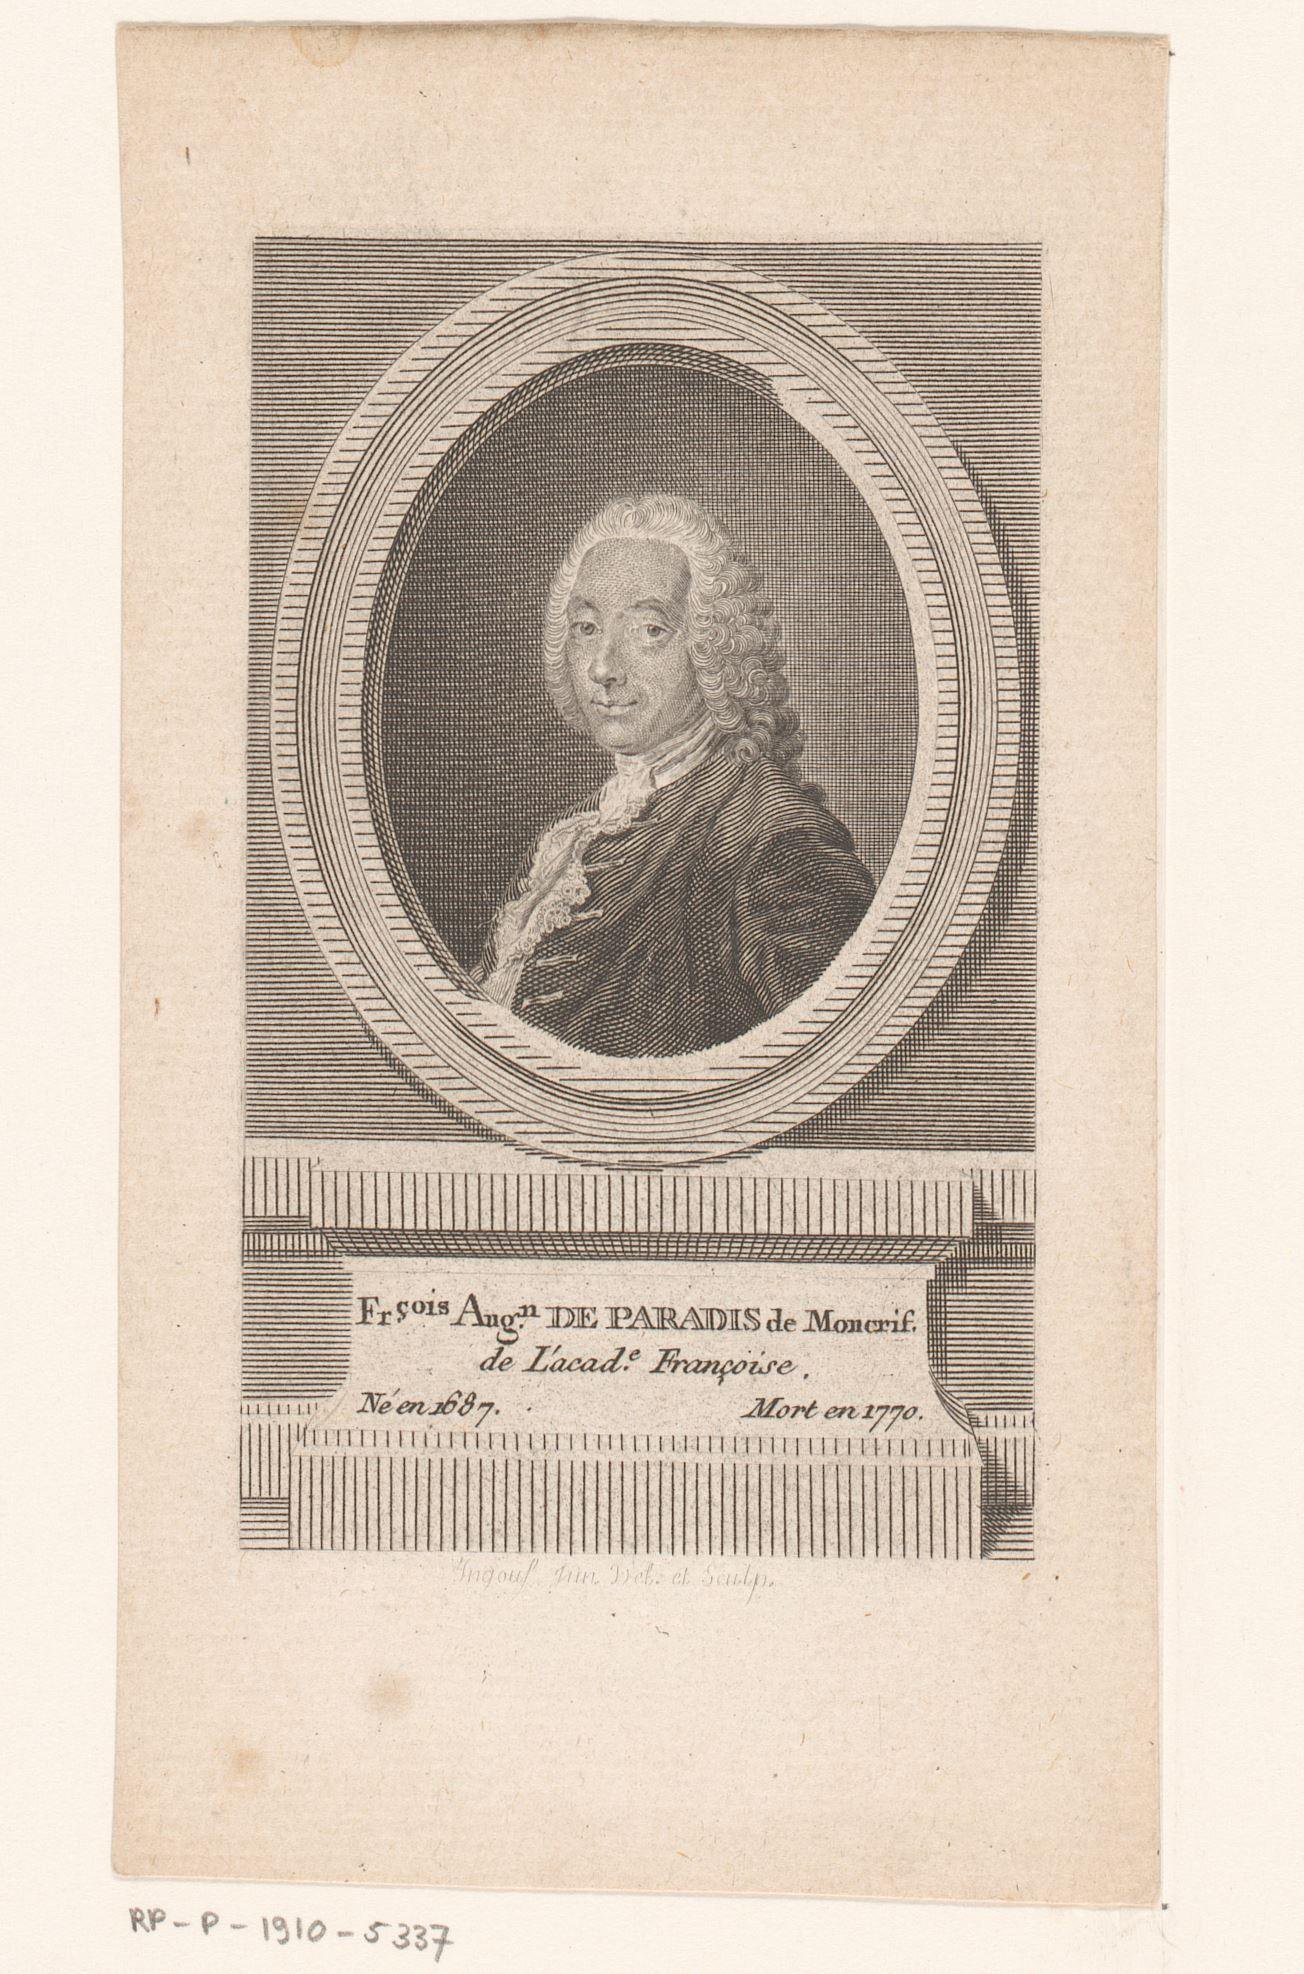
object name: print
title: Portret van François-Augustin de Paradis de Moncrif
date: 1778-1787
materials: paper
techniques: engraving, etching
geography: paris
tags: paris, historical persons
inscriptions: collector's mark: Lugt 2228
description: Prent uit: Annales poétiques, ou Almanach des Muses. Parijs: Delalain, 1778-1787, dl. 36.